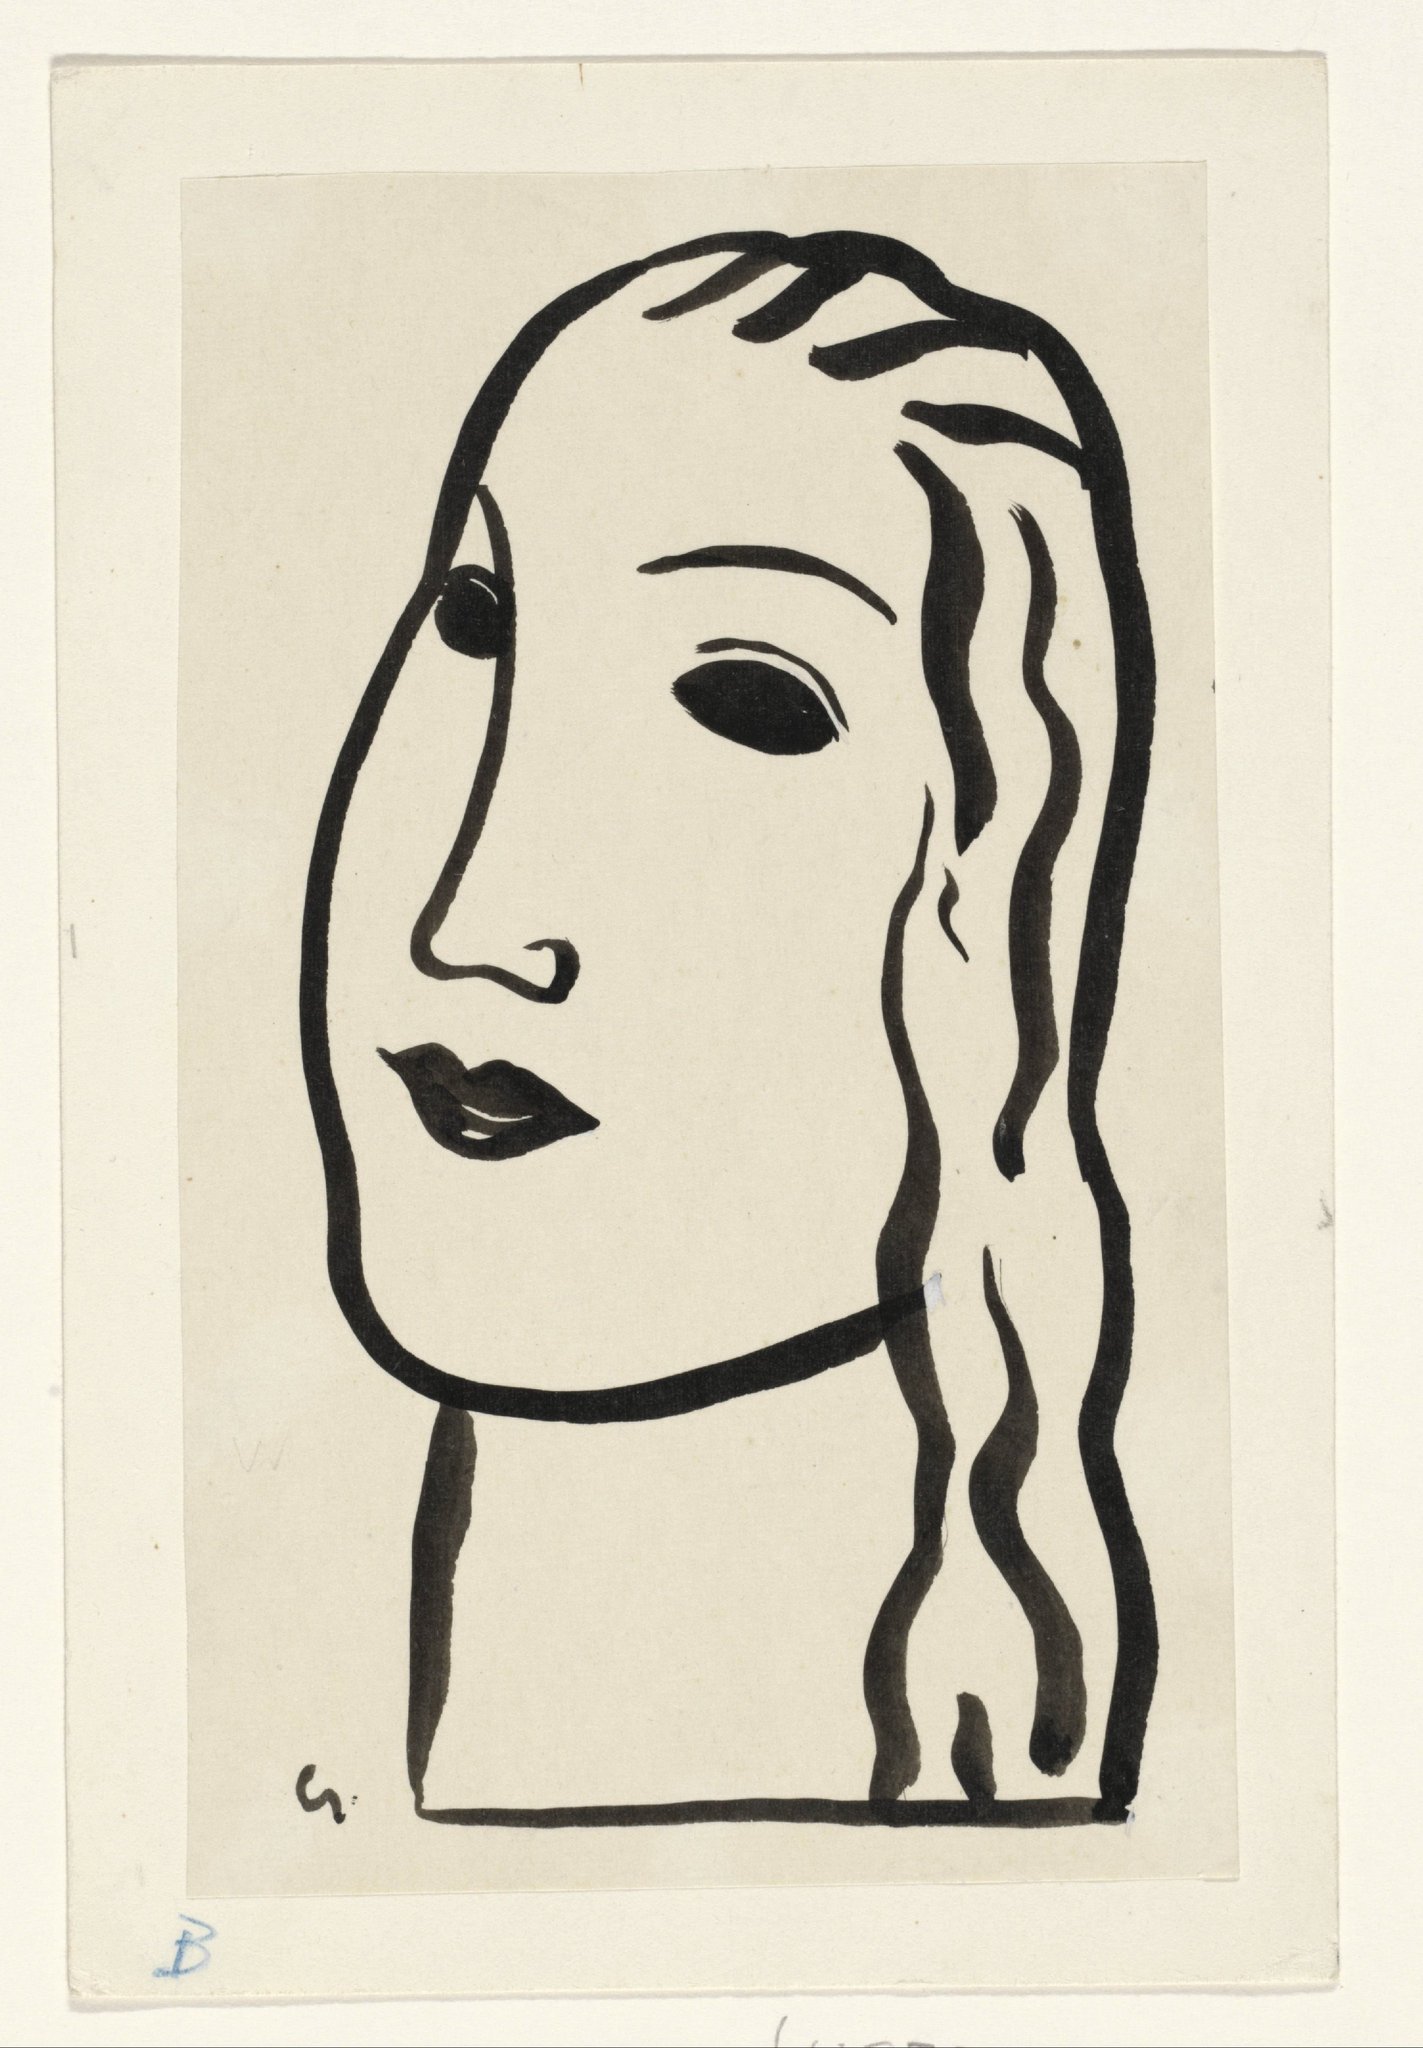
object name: design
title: Vrouwenhoofd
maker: leo gestel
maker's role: draughtsman, print maker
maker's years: 1881-1941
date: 1891-1941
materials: paint, ink, paper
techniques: brush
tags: head (human) - aa - female human figure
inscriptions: collector's mark: Lugt 2228